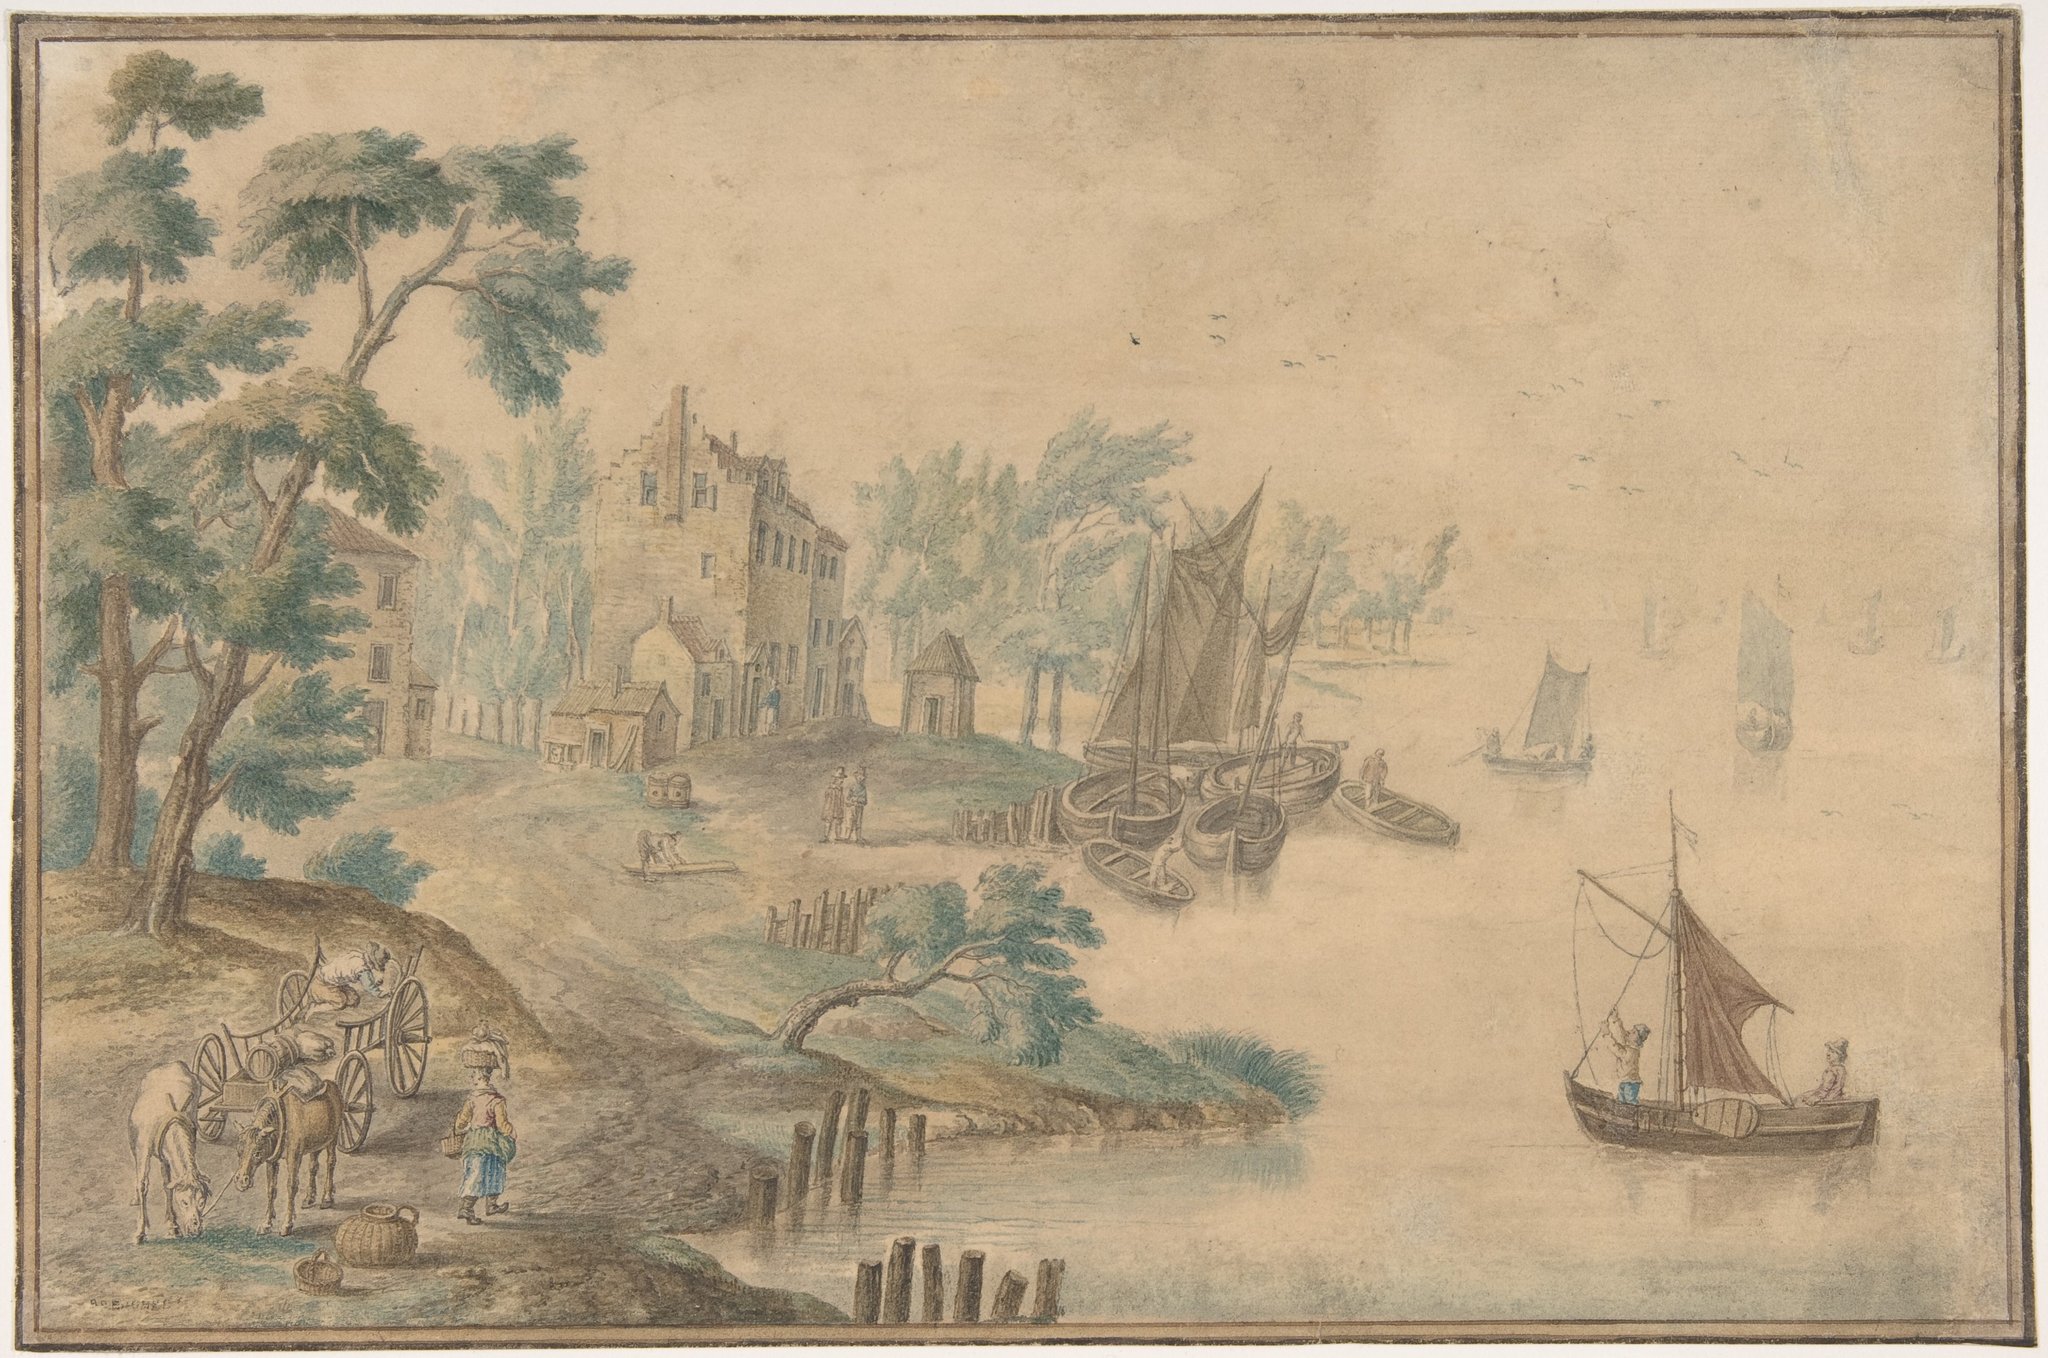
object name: drawing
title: Landscape with Horses and Carts and a River at Right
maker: anonymous, flemish, 18th century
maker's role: artist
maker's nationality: flemish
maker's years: 1700-1800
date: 1701-1800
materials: chalk, gilt, ink, watercolor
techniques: pen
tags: horses,rivers,landscapes,boats,carriages